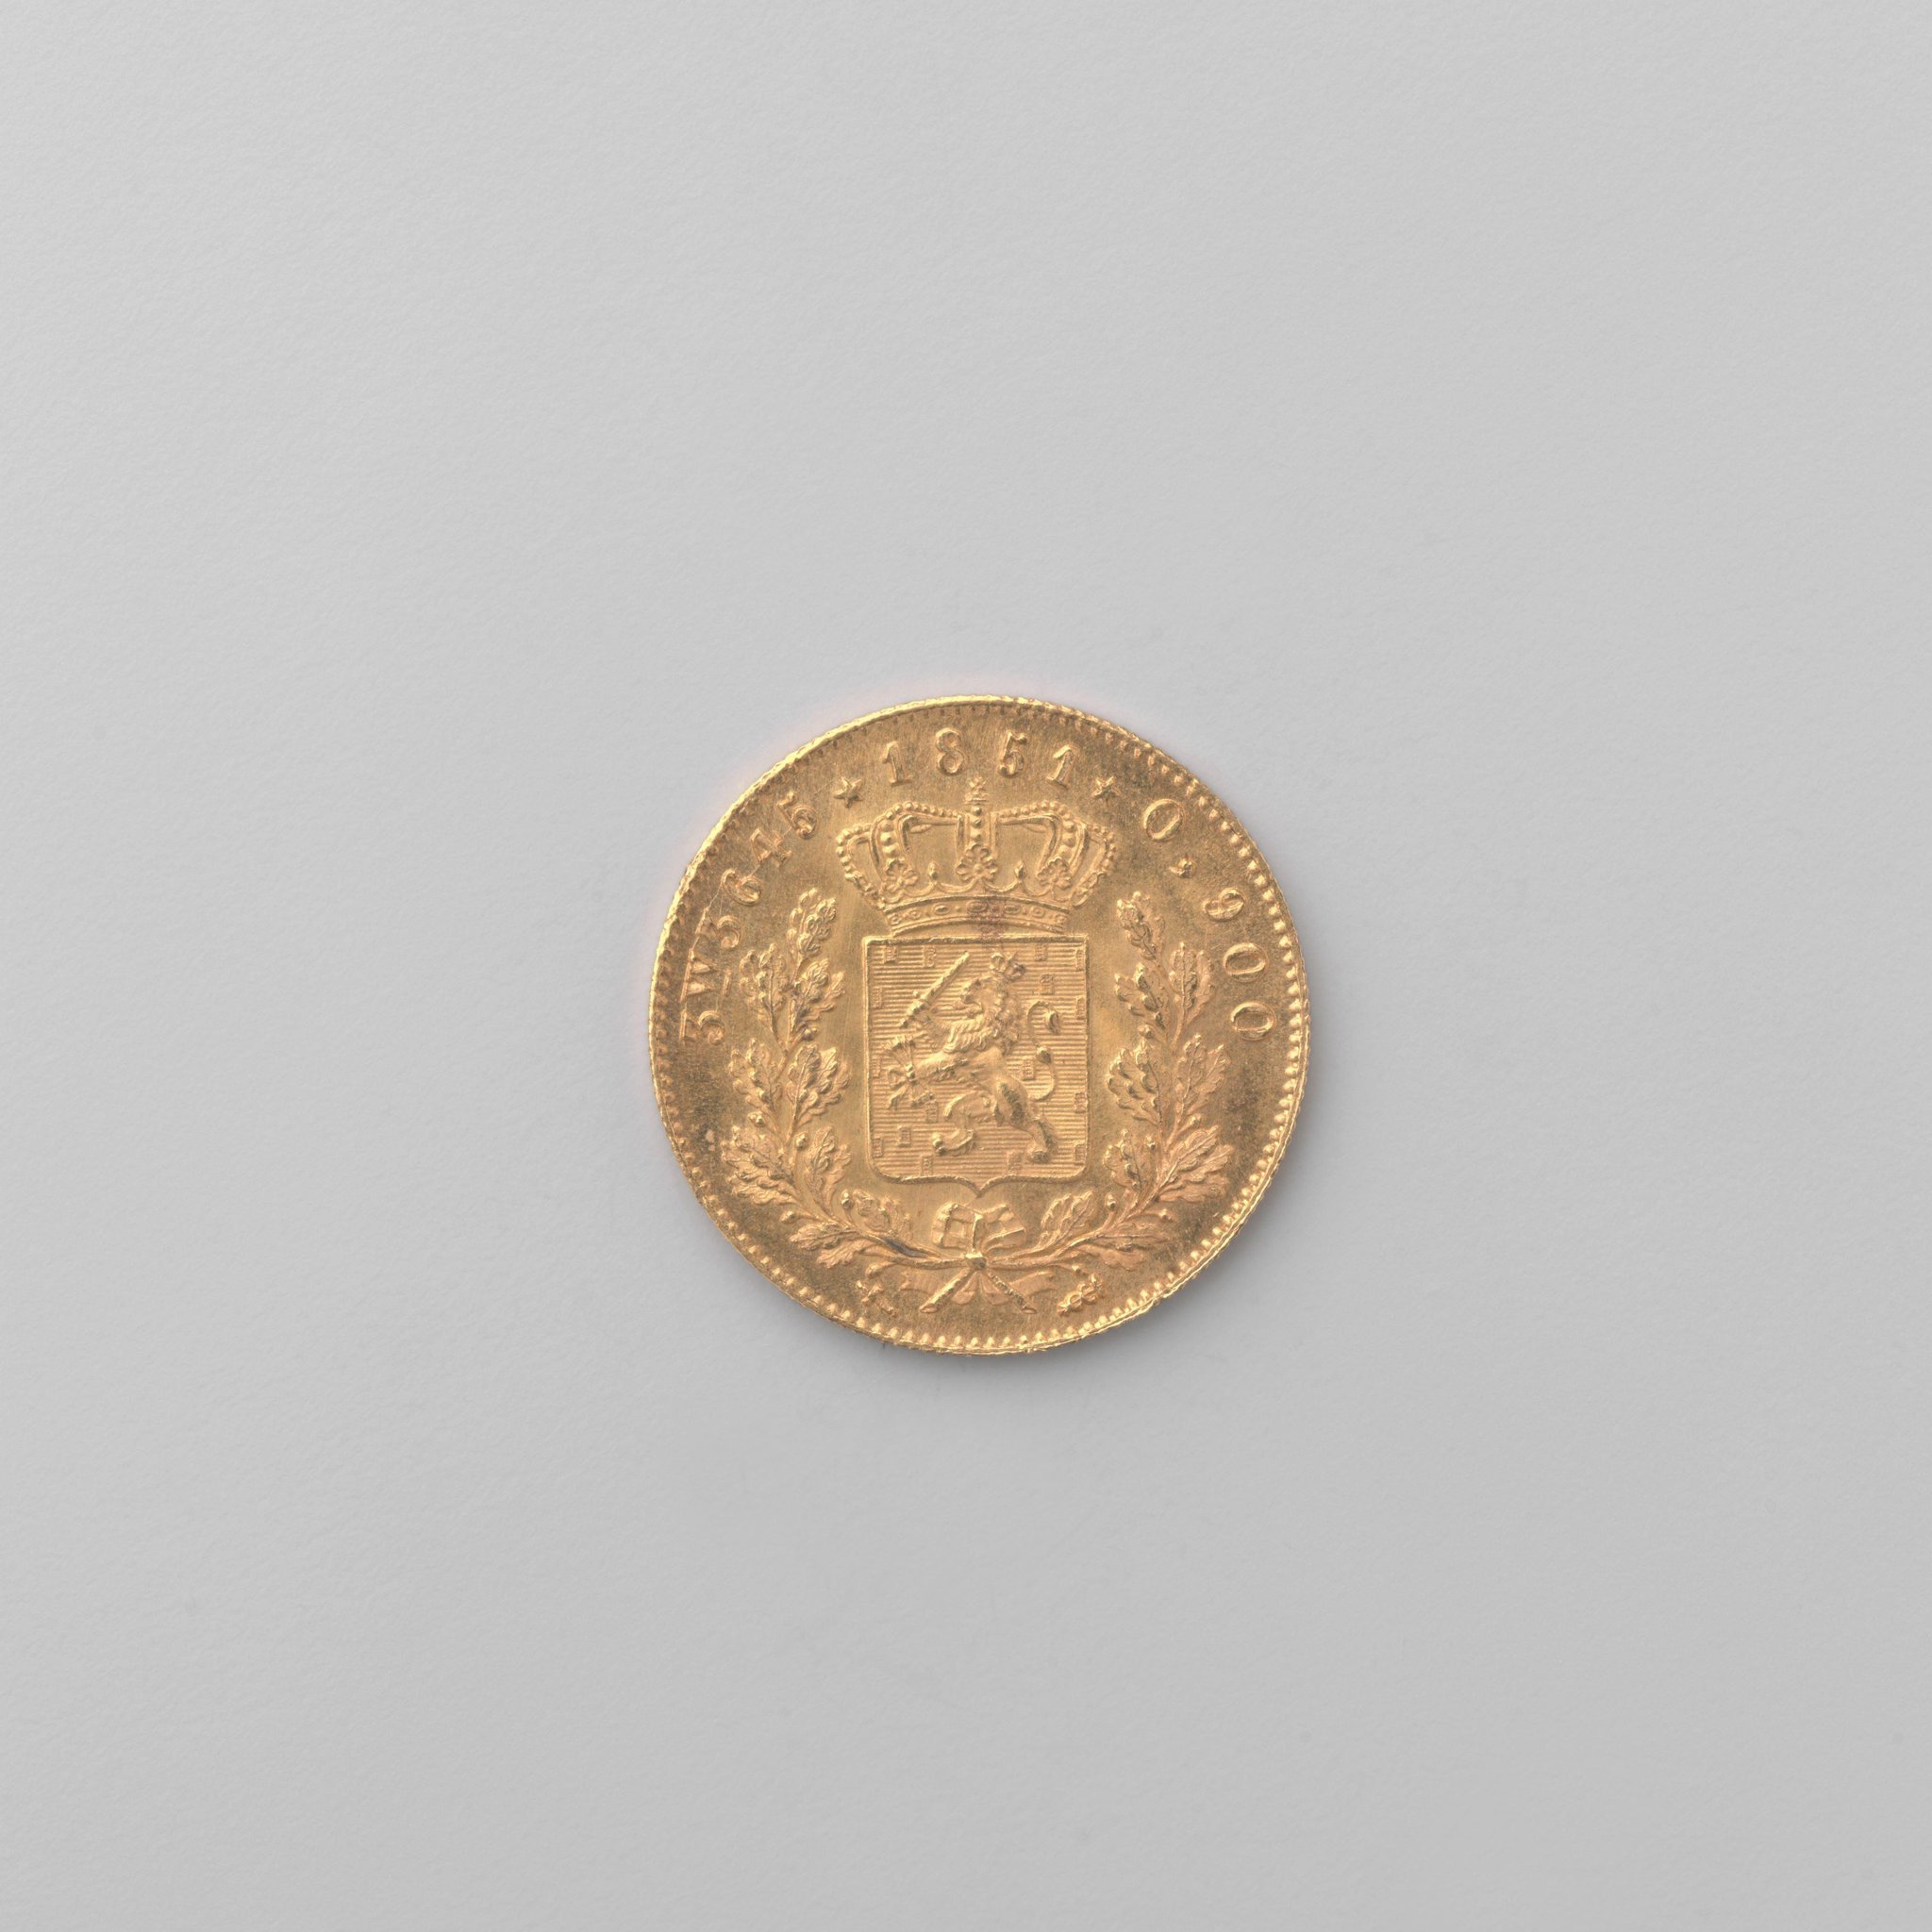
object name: halve willem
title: Nederland, halve negotiepenning of halve Willem, 1851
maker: willem iii (koning der nederlanden)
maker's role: koning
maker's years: 1817-1890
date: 1851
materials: gold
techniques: striking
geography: utrecht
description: Gouden munt. Voorzijde: borstbeeld naar links. Keerzijde: tussen twee samengebonden eiketakken gekroond rijkswapenschild. Omschrift: Jaartal, boven kroon, gewicht- en gehalte-aanduiding. Randschrift.